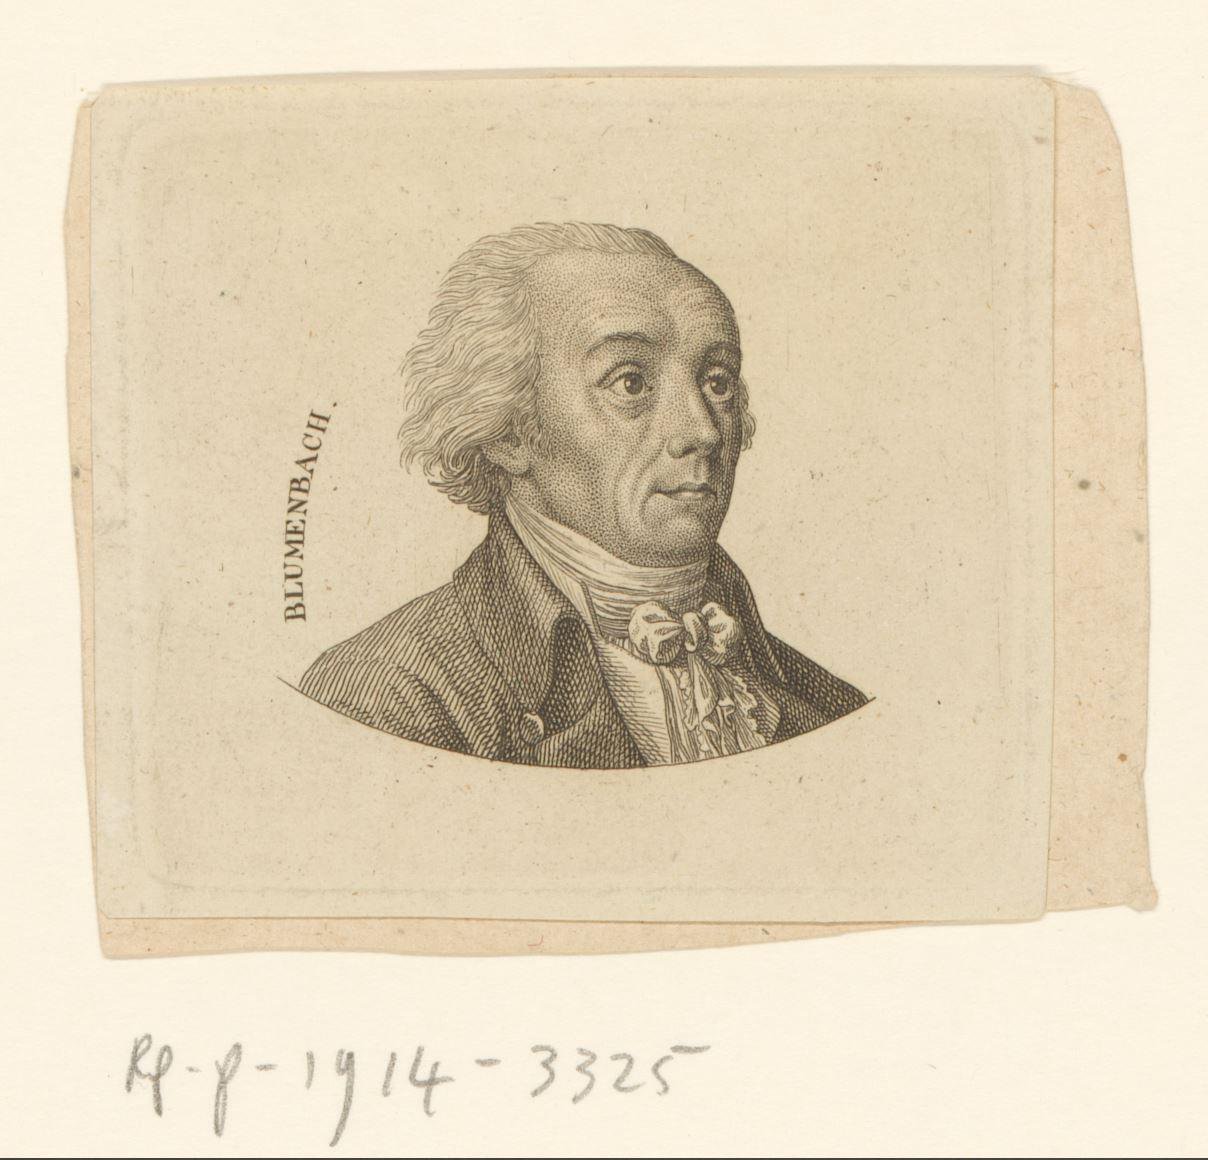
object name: print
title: Portret van Johann Friedrich Blumenbach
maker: ernst ludwig riepenhausen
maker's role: print maker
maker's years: 1765-1840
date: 1775-1840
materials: paper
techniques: engraving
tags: physicist, historical persons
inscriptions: collector's mark: Lugt 2228